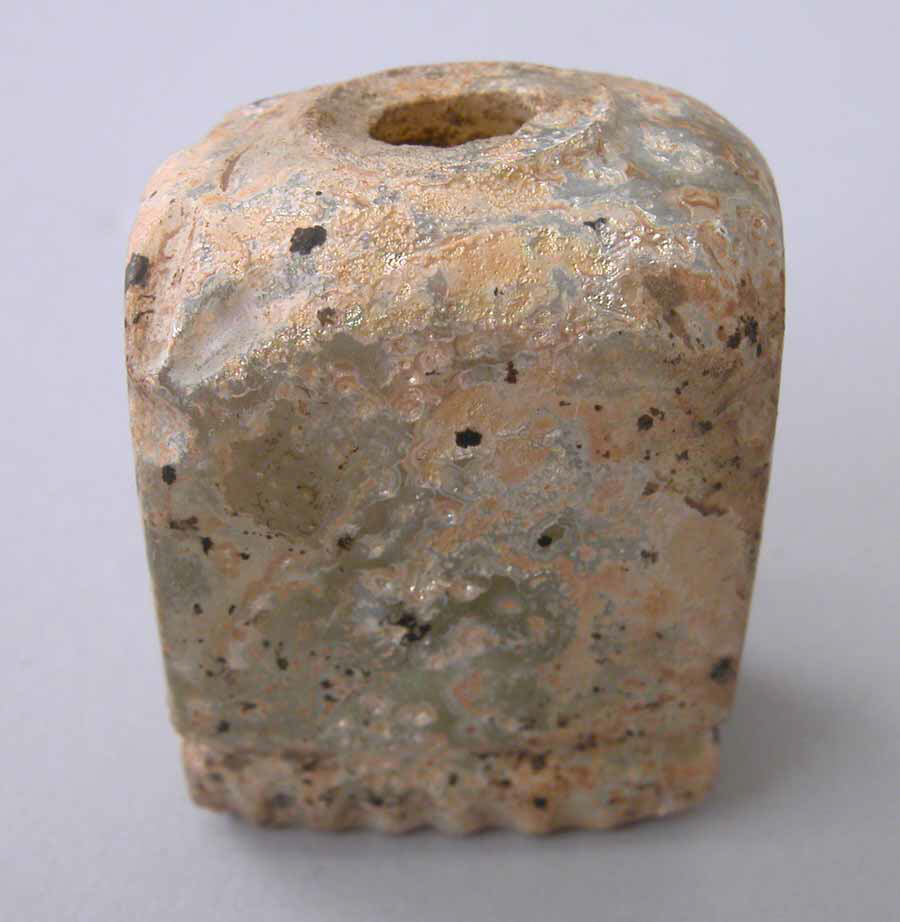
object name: flask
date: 601-800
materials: glass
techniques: glassblowing, cutting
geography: iraq